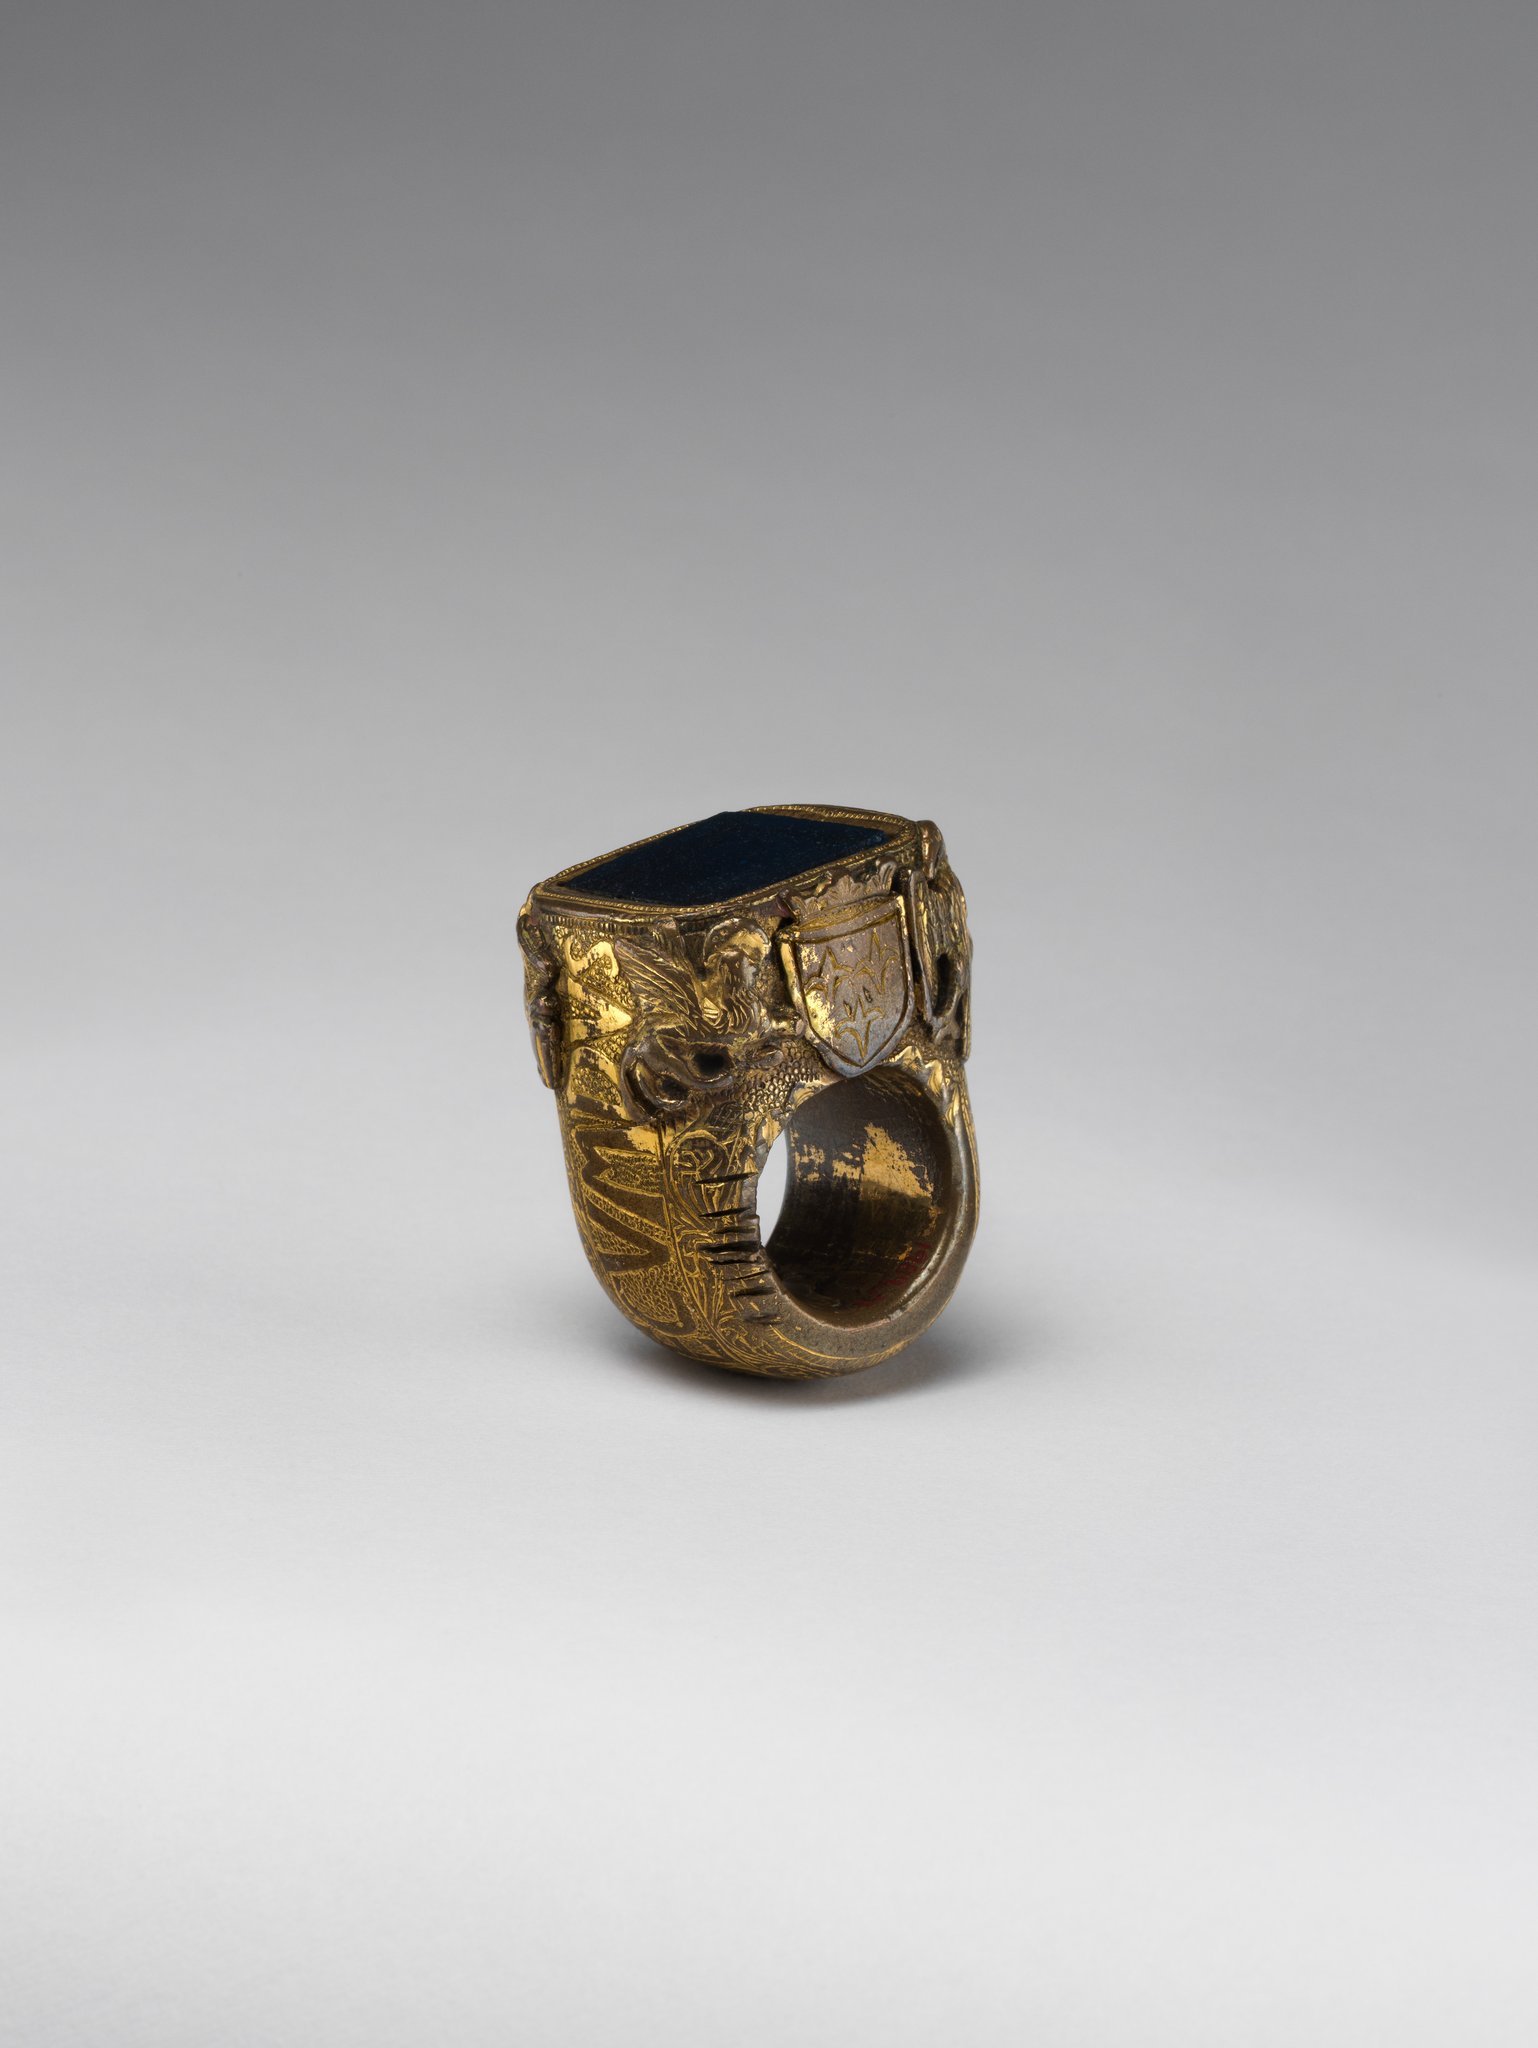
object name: ring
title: Ring with the Name of Pope Paul II (r. 1464–71)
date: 1464-1471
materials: brass, gilt, glass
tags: eagles,lions,coat of arms